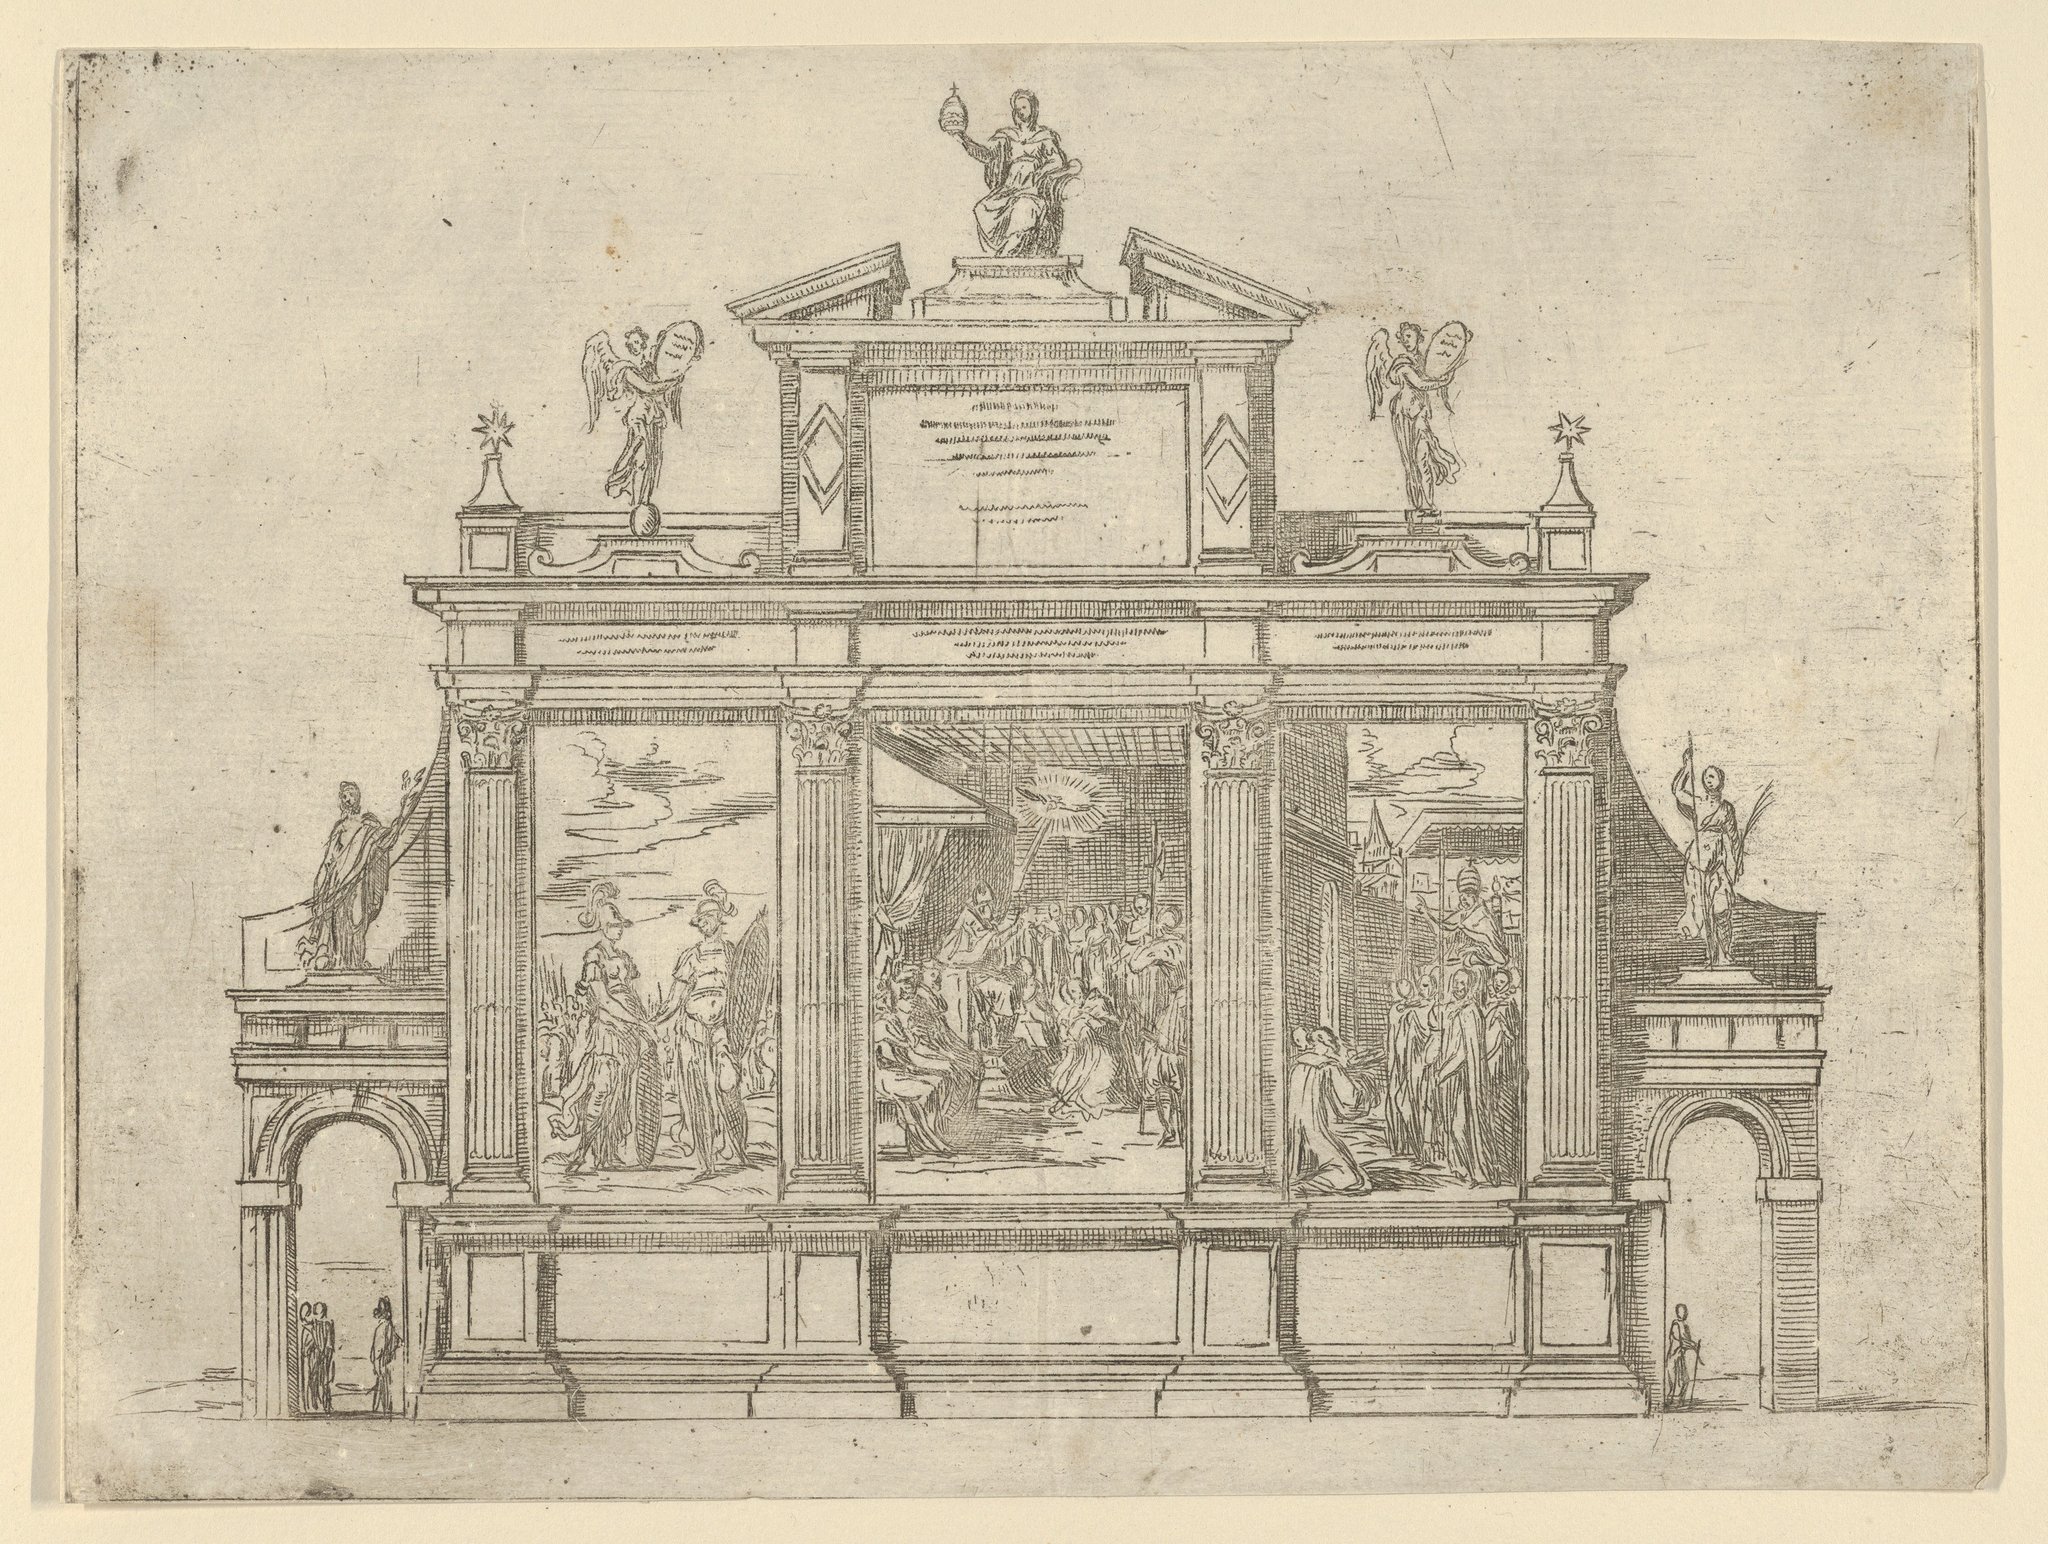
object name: print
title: Façade of a triumphal monument with three scenes depicting deeds of Pope Clement VIII, a temporary decoration for the entry of Pope Clement VIII in Bologna in 1598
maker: guido reni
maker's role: artist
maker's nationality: italian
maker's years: 1575-1642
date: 1598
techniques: etching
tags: monuments